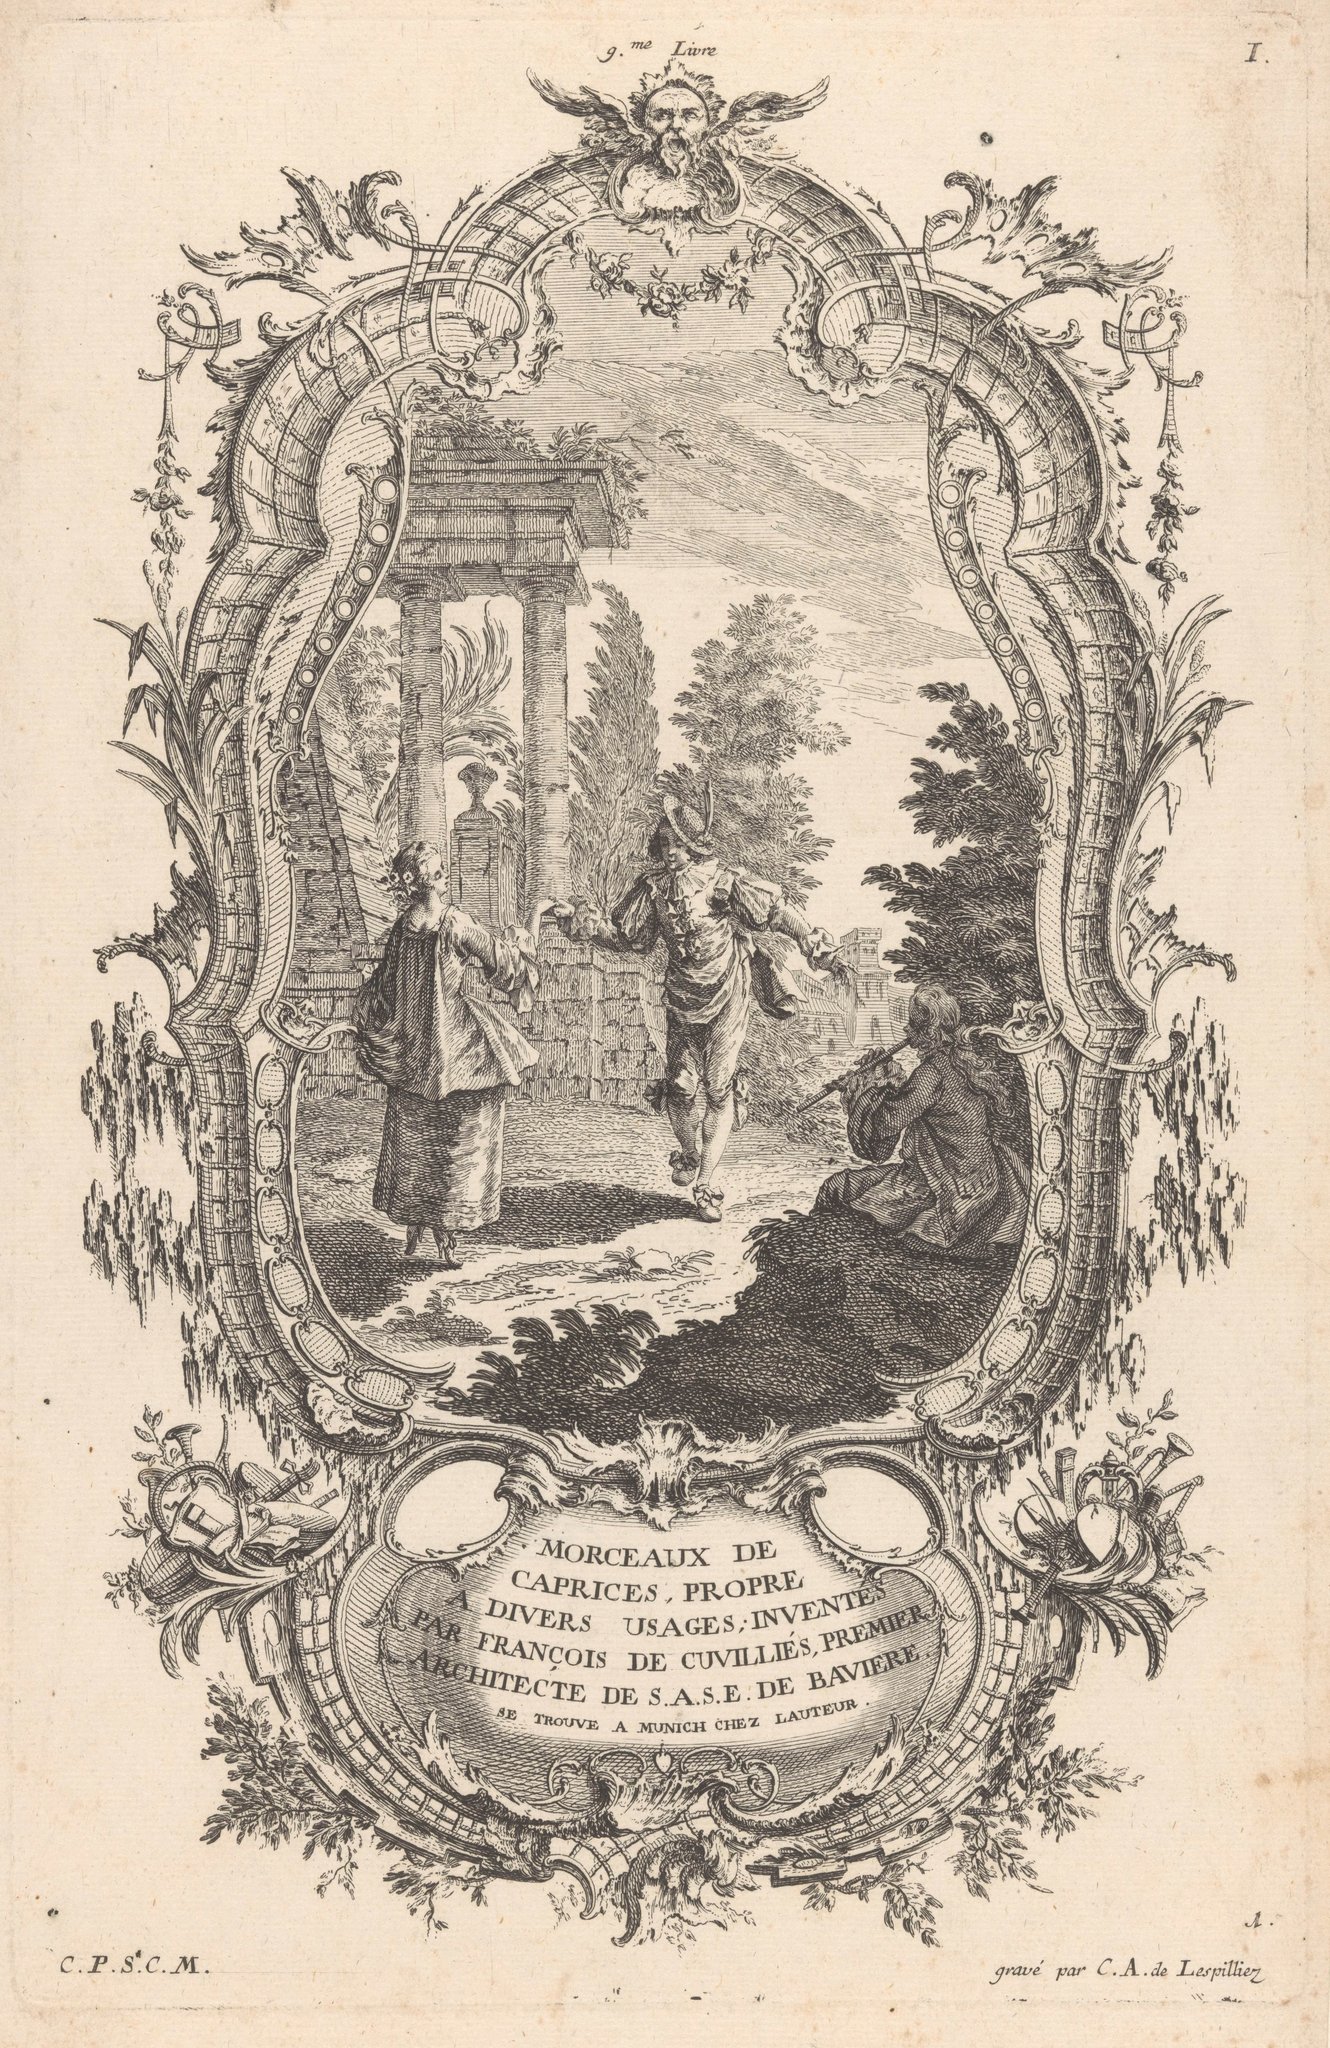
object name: print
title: Dansend paar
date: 1745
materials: paper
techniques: engraving, etching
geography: germany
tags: one pair dancing; man and woman dancing as a couple, one person playing an instrument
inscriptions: collector's mark: Lugt 2228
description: Een man en een vrouw dansen op de muziek van de zittende fluitspeler rechts in het landschap. Rondom de voorstelling een geornamenteerde omlijsting, daaronder de serietitel in een cartouche.